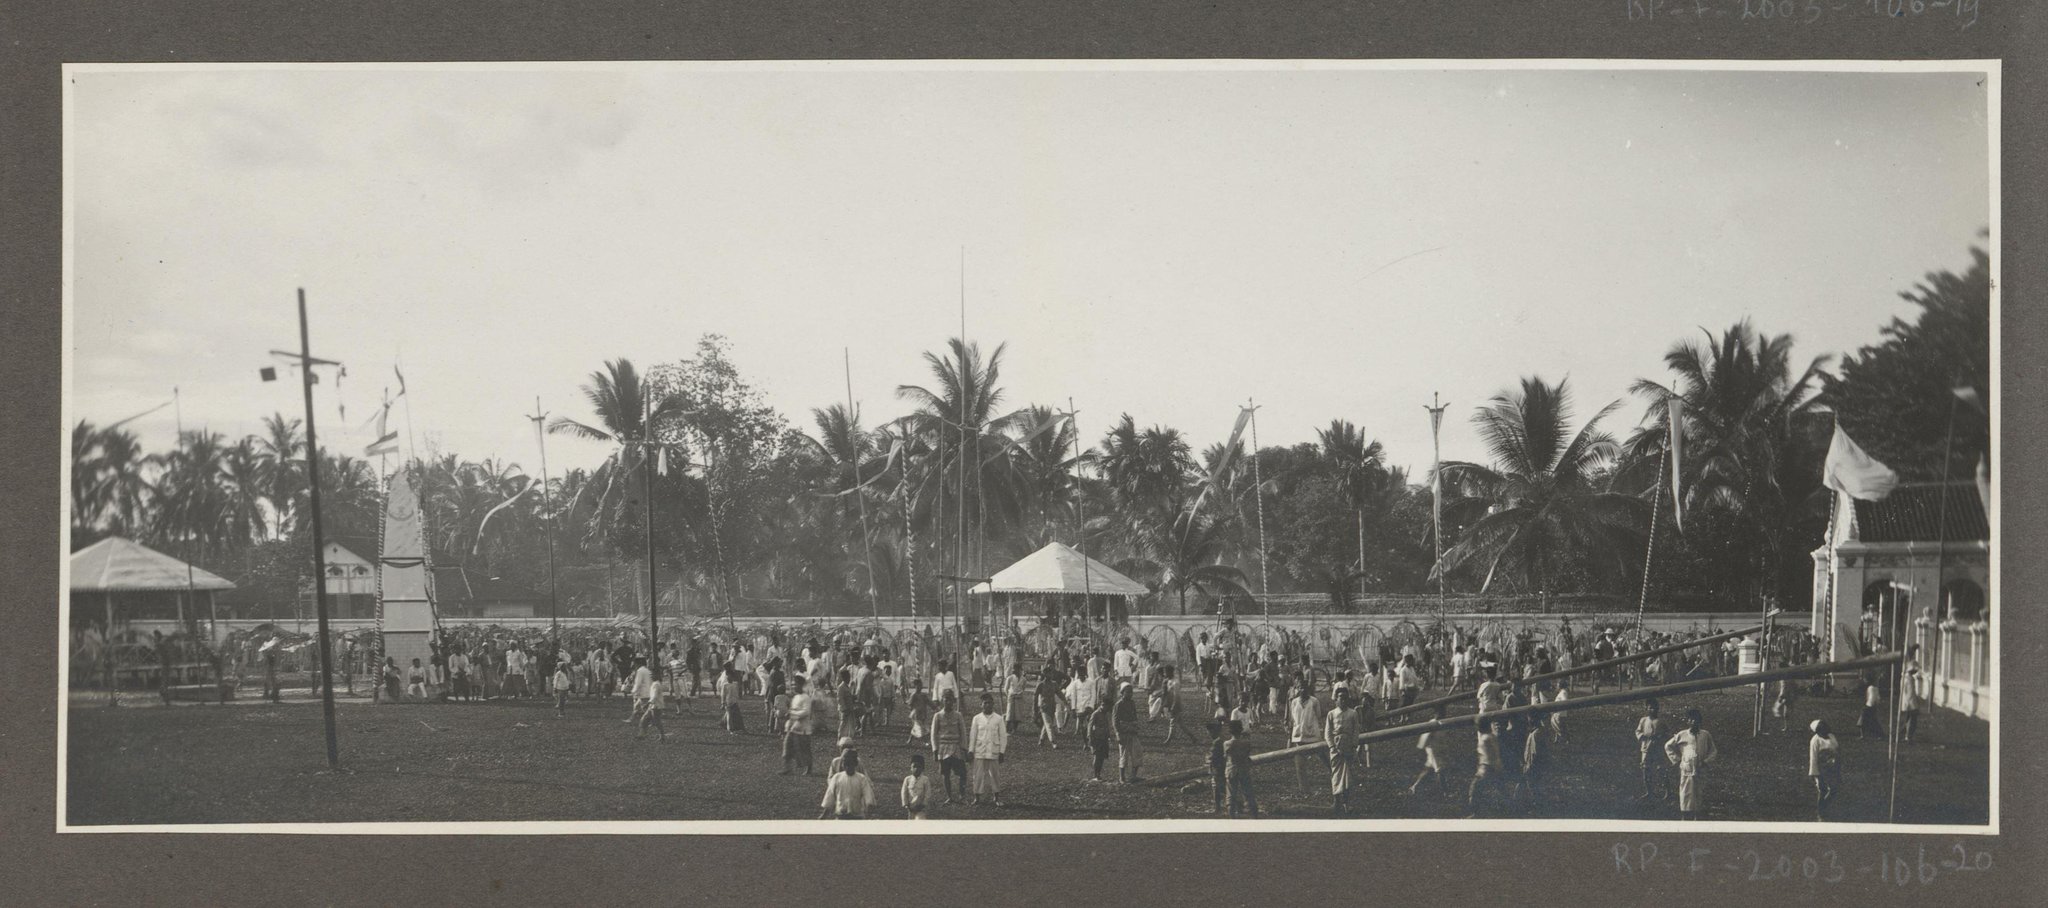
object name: album leaf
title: Panorama van het feestterrein voor het paleis van de Sultan van Langkat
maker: Anonymous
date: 1919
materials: photographic support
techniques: gelatin silver print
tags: garden, palace, festivities, sumatra